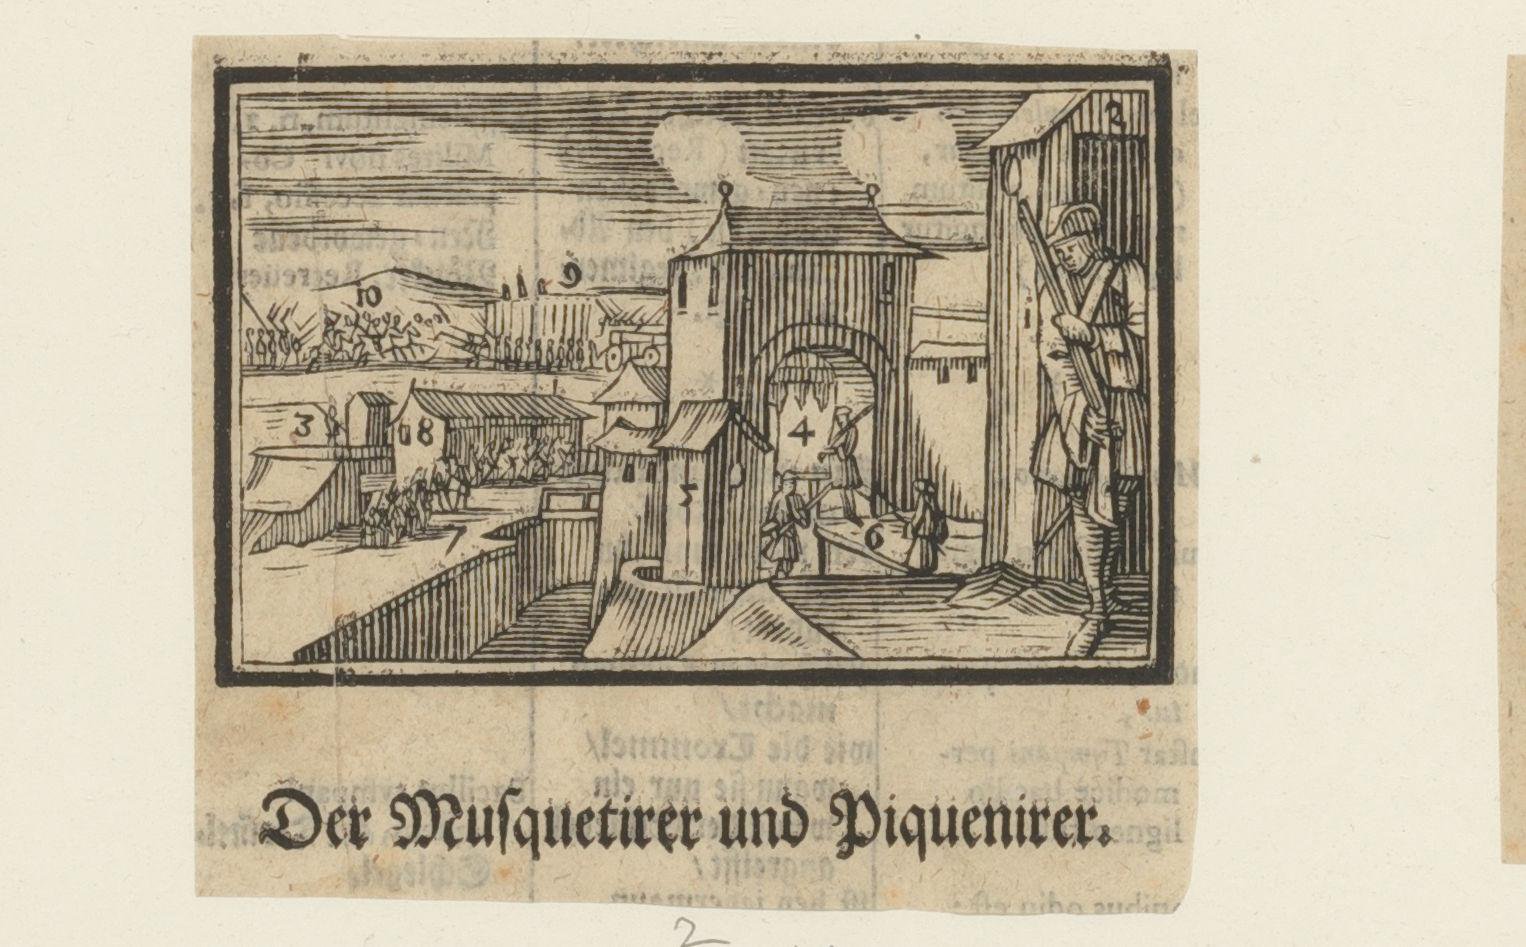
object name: print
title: Musketiers en piekeniers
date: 1719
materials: paper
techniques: letterpress printing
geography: nuremberg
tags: helved weapons, polearms (for striking, hacking, thrusting): pike, private soldier, firearms: rifle, hand-to-hand fighting (~ battle)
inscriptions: stamp, collector's mark: Lugt 1641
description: Prent uit: Comenius, Johannes Amosius. Orbis sensualium picti pars prima (...). Neurenberg: Martin Endter, 1719, dl. 2, p. 288. Prent eerder gebruikt in: Comenius, Johannes Amosius. Orbis Sensualium Picti denuo aucti Pars Secunda (...). Neurenberg: Martin Endter, 1730, dl. 2.